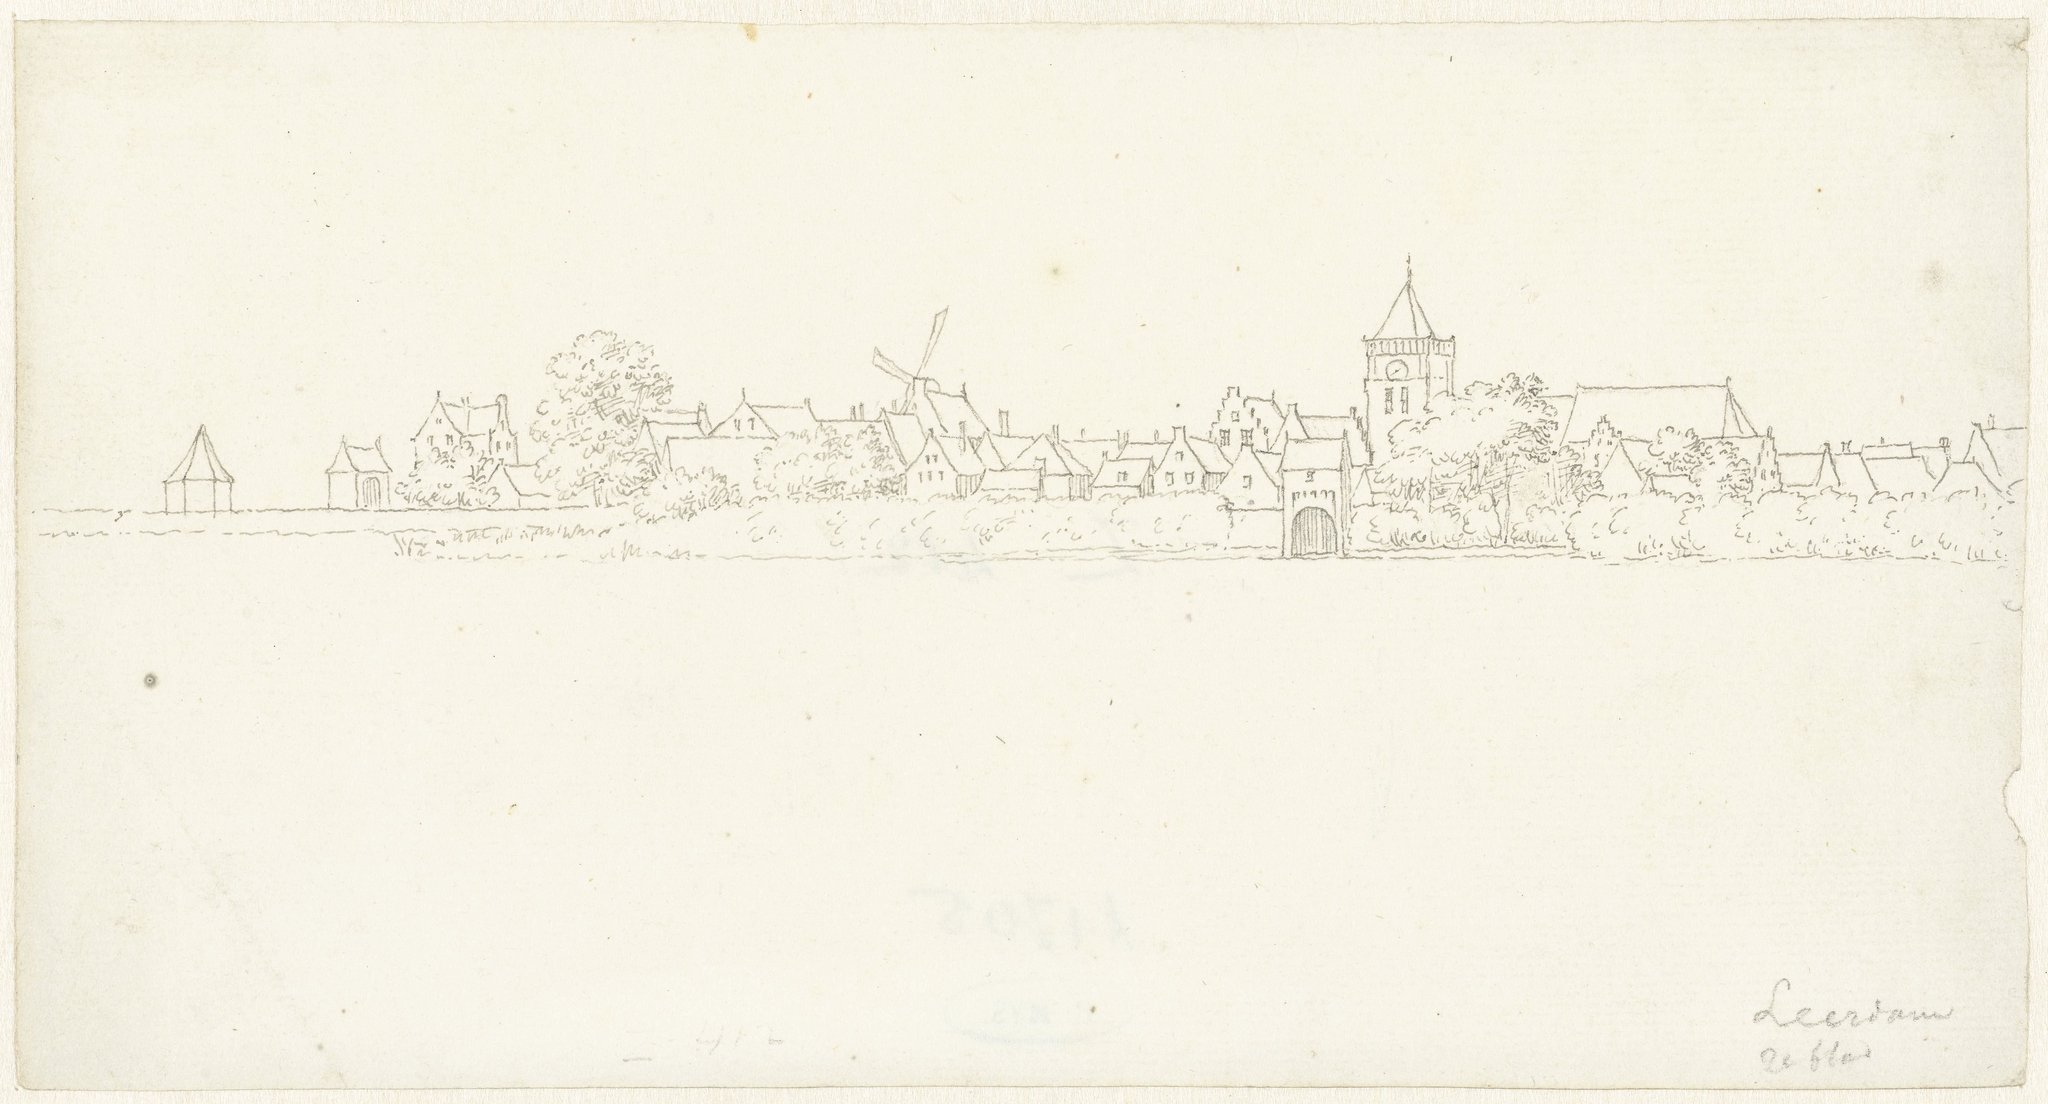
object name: drawing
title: Gezicht op Leerdam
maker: cornelis pronk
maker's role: draughtsman, painter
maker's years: 1691-1759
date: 1701-1759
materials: ink, paper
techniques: pen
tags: city-walls, prospect of city, town panorama, silhouette of city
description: Gezicht op Leerdam. Rechtsonder: Leerdam 2e blad.